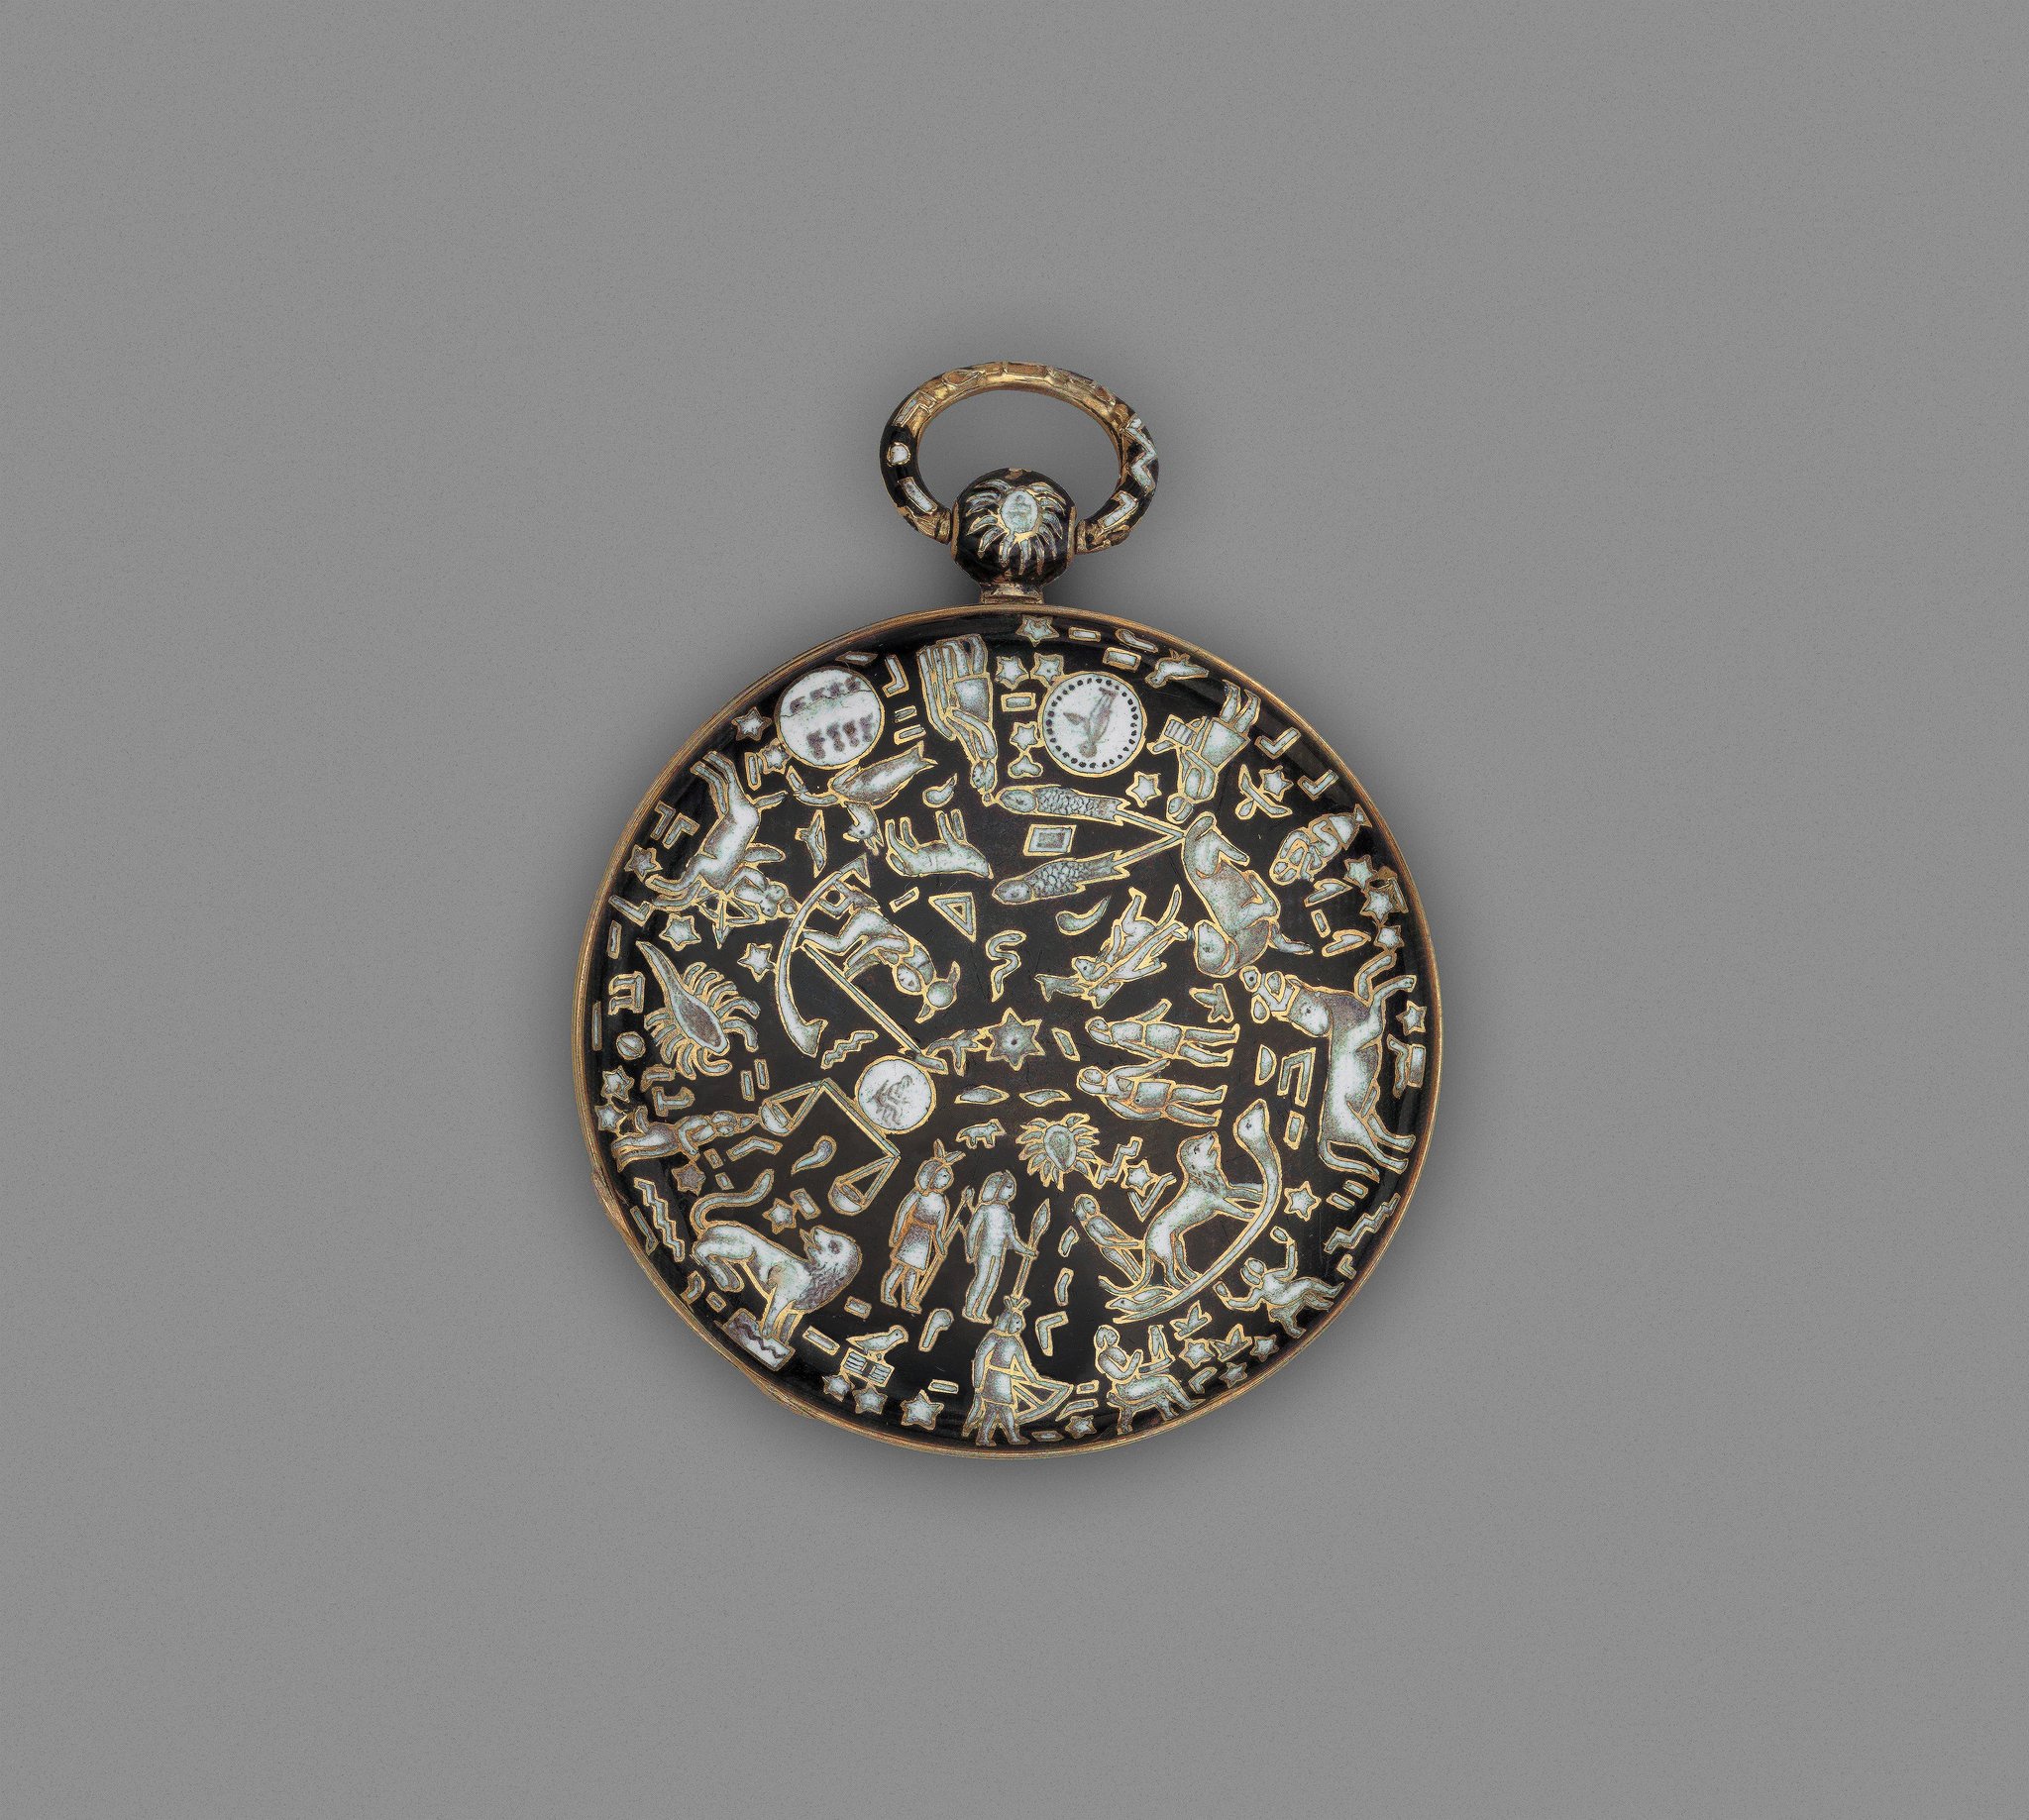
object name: watch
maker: firm of bautte et moynier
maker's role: maker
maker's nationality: swiss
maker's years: 1826-1831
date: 1826-1831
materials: gilt brass, gold, gemstone, steel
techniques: enamel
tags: scorpions,lions,snakes